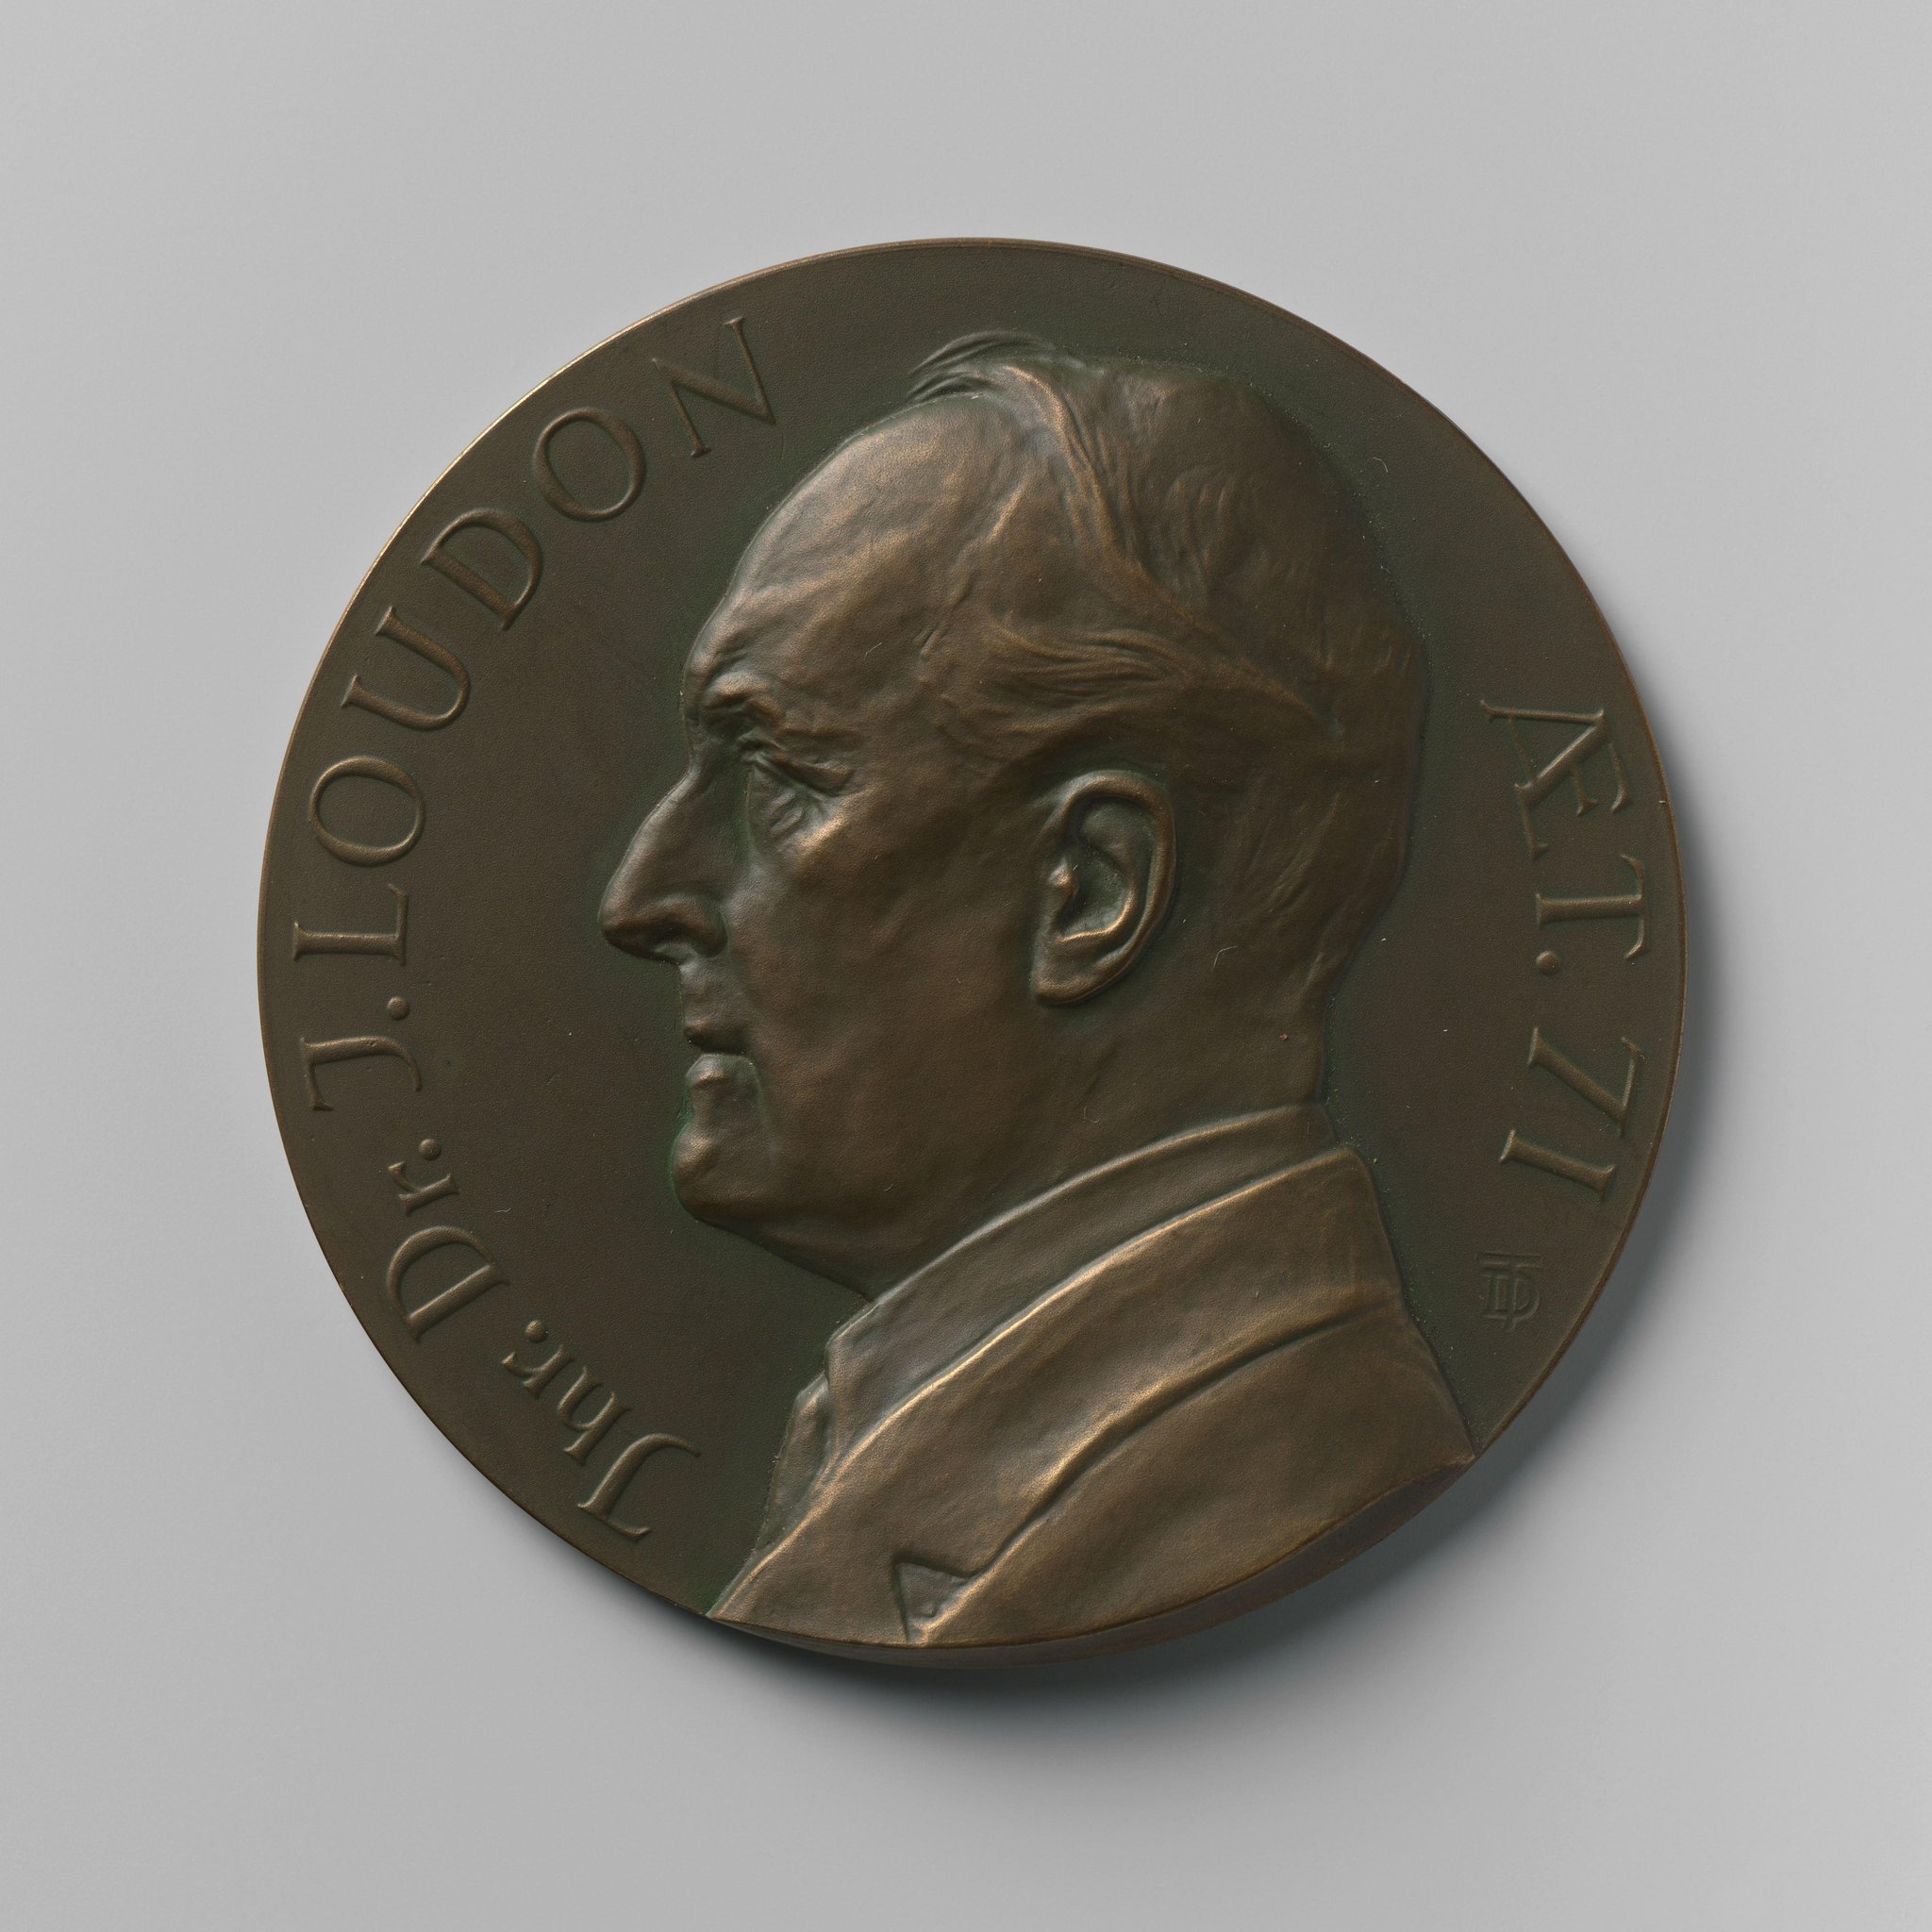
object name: history medal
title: Jonkheer doctor J. Loudon (Vereniging voor Penningkunst 1937, tweede penning)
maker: toon dupuis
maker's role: sculptor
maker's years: 1877-1937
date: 1937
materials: bronze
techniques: striking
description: Bronzen penning, op de voorzijde het borstbeeld van Loudon naar links met omschrift, op de keerzijde vier regels tekst en het jaartal, met verklaring.